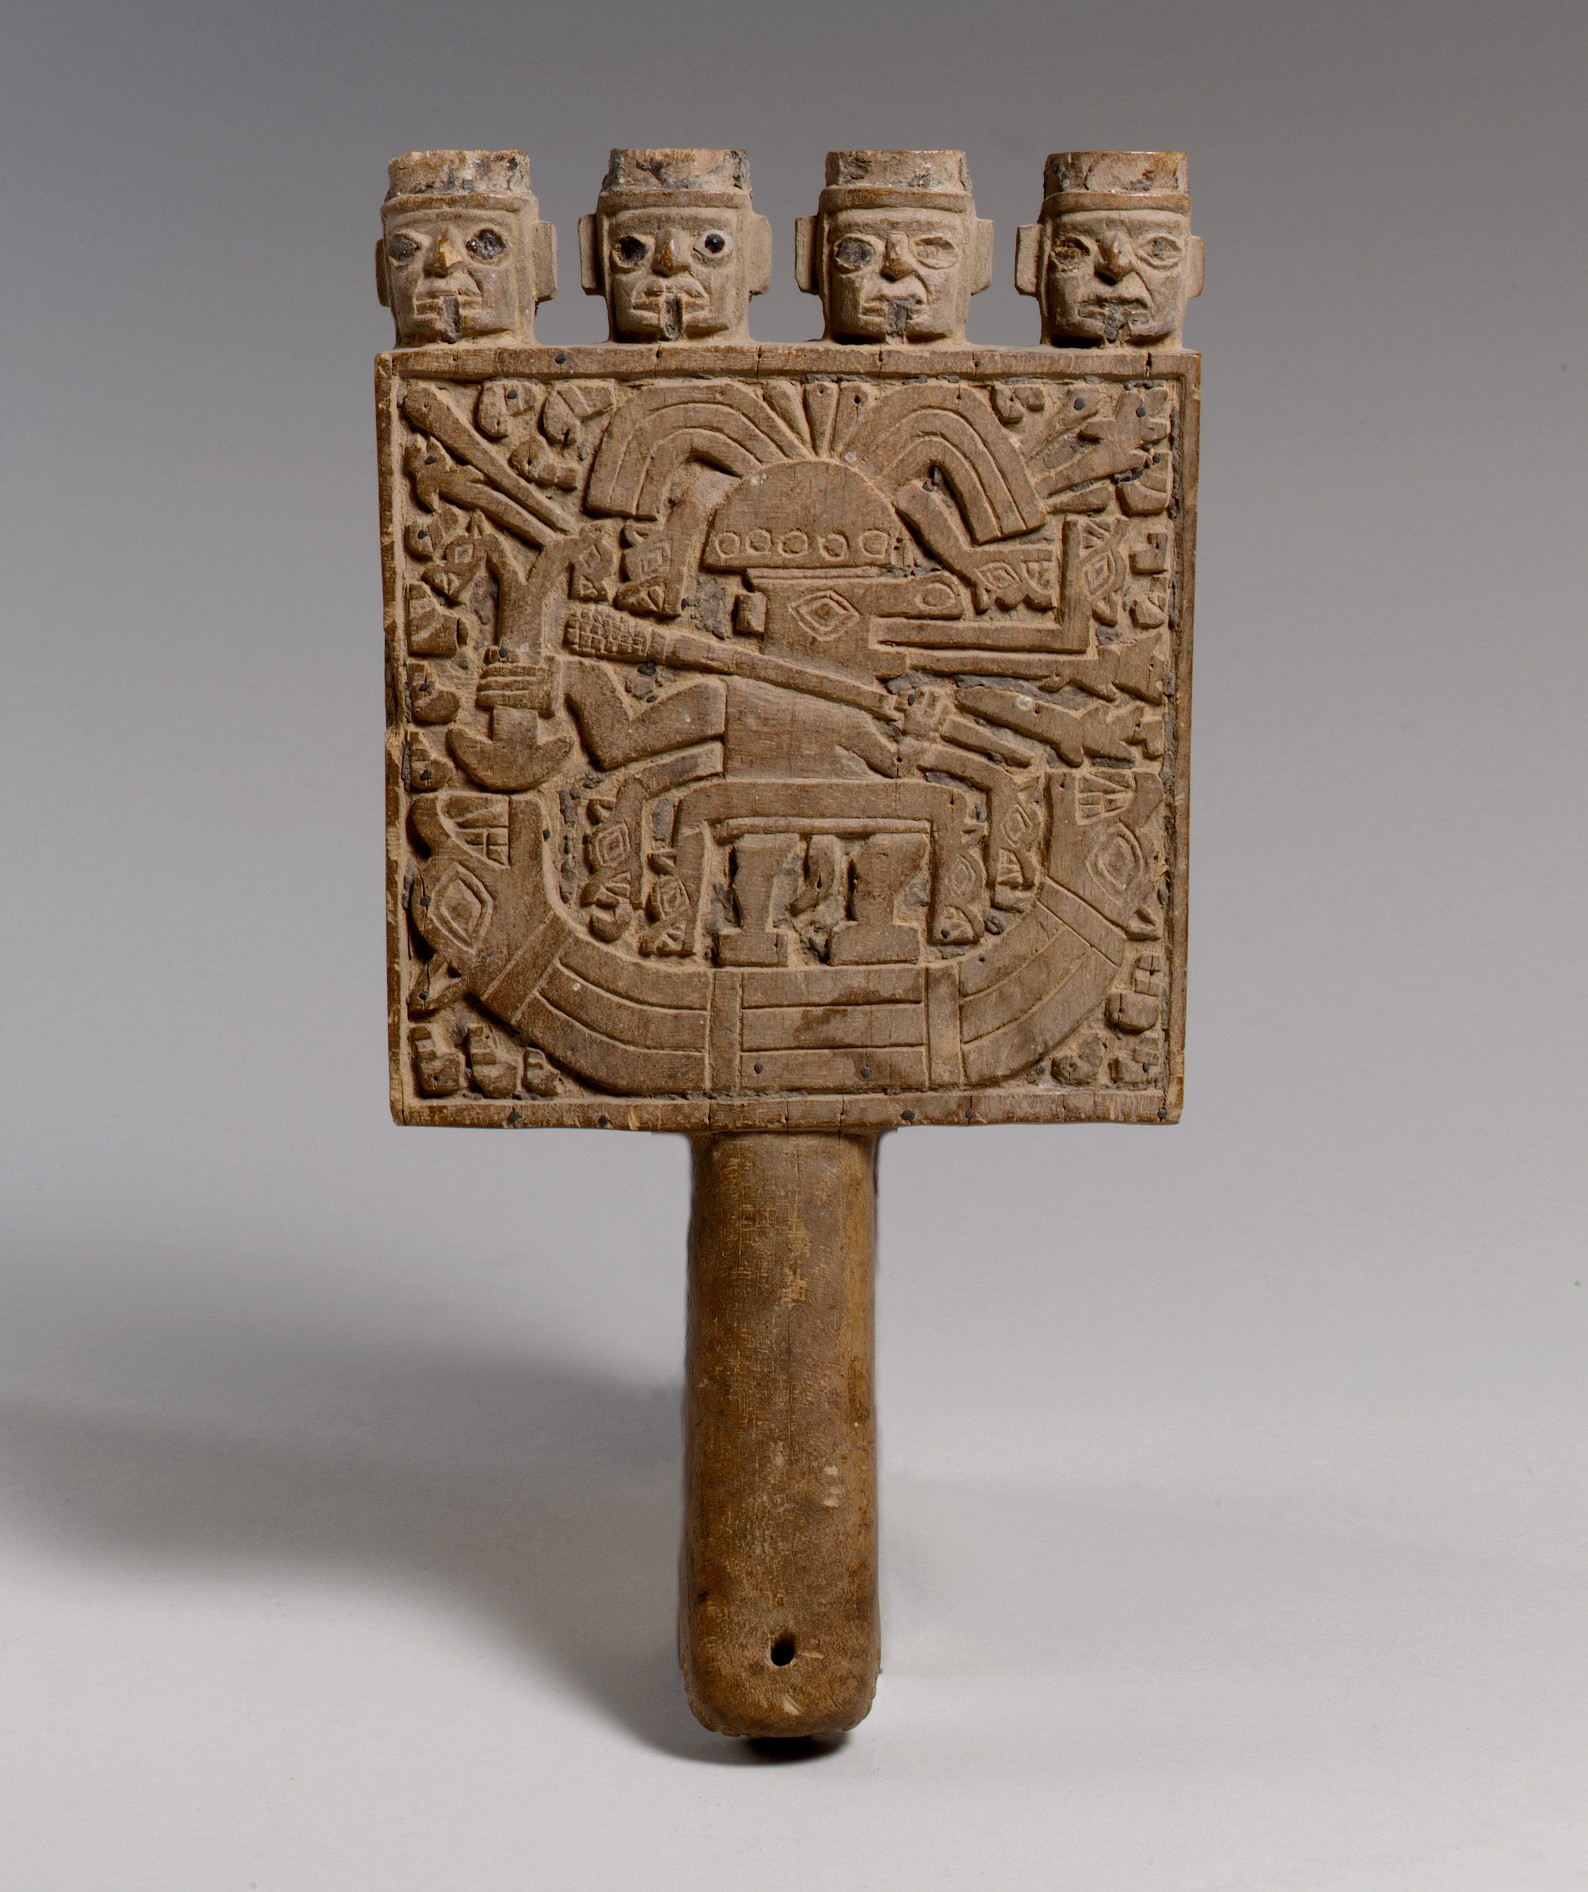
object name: mirror frame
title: Mirror with figure in a reed boat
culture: wari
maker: wari artist(s)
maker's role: artist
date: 650-1000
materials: alloy, pigment, shell, silver, wood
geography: peru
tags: heads,men,boats